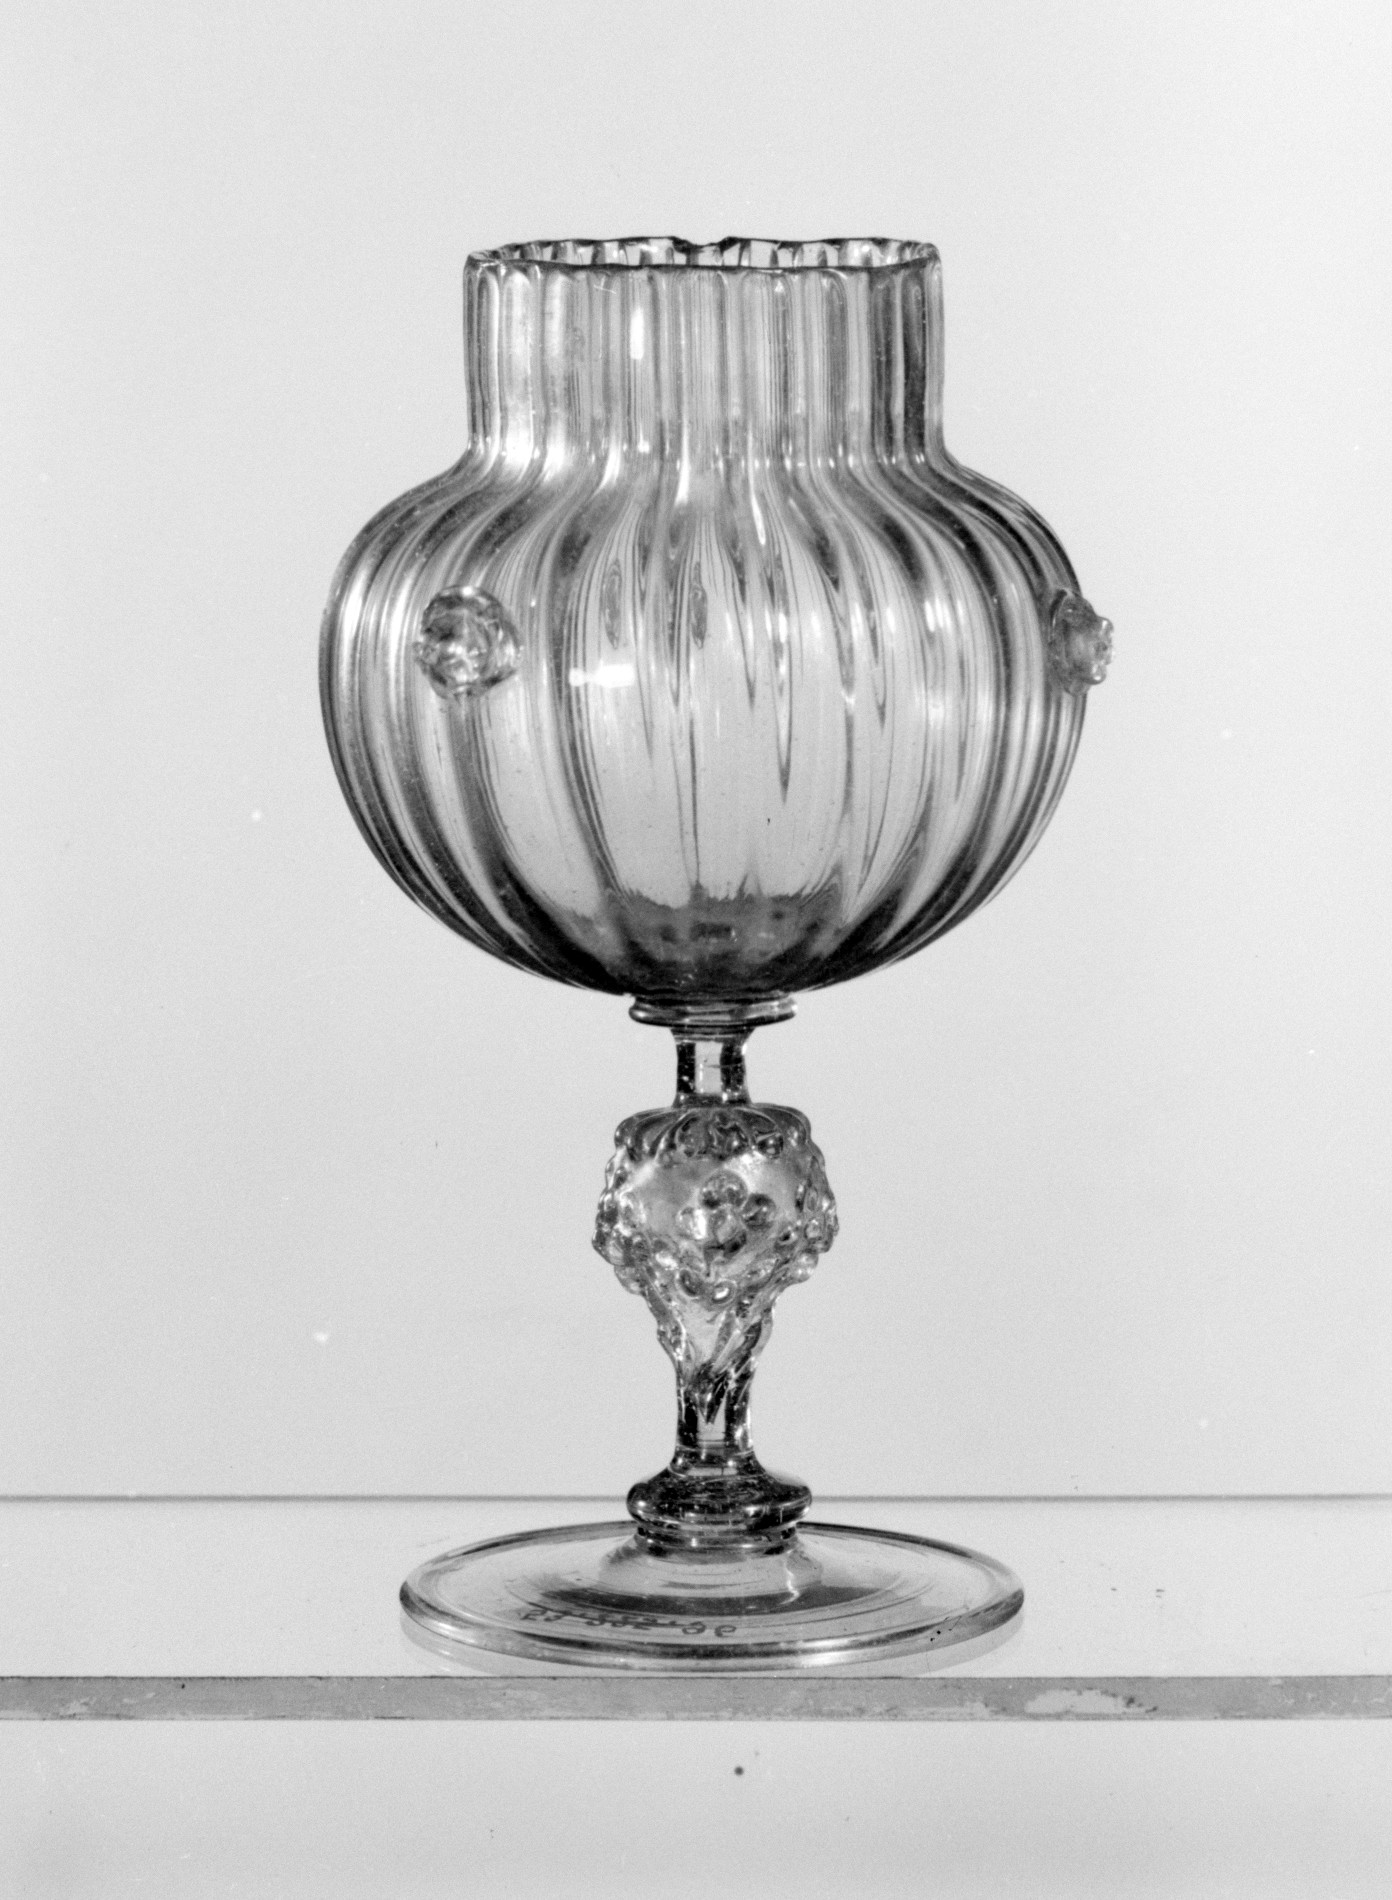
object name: goblet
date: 1567-1600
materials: glass